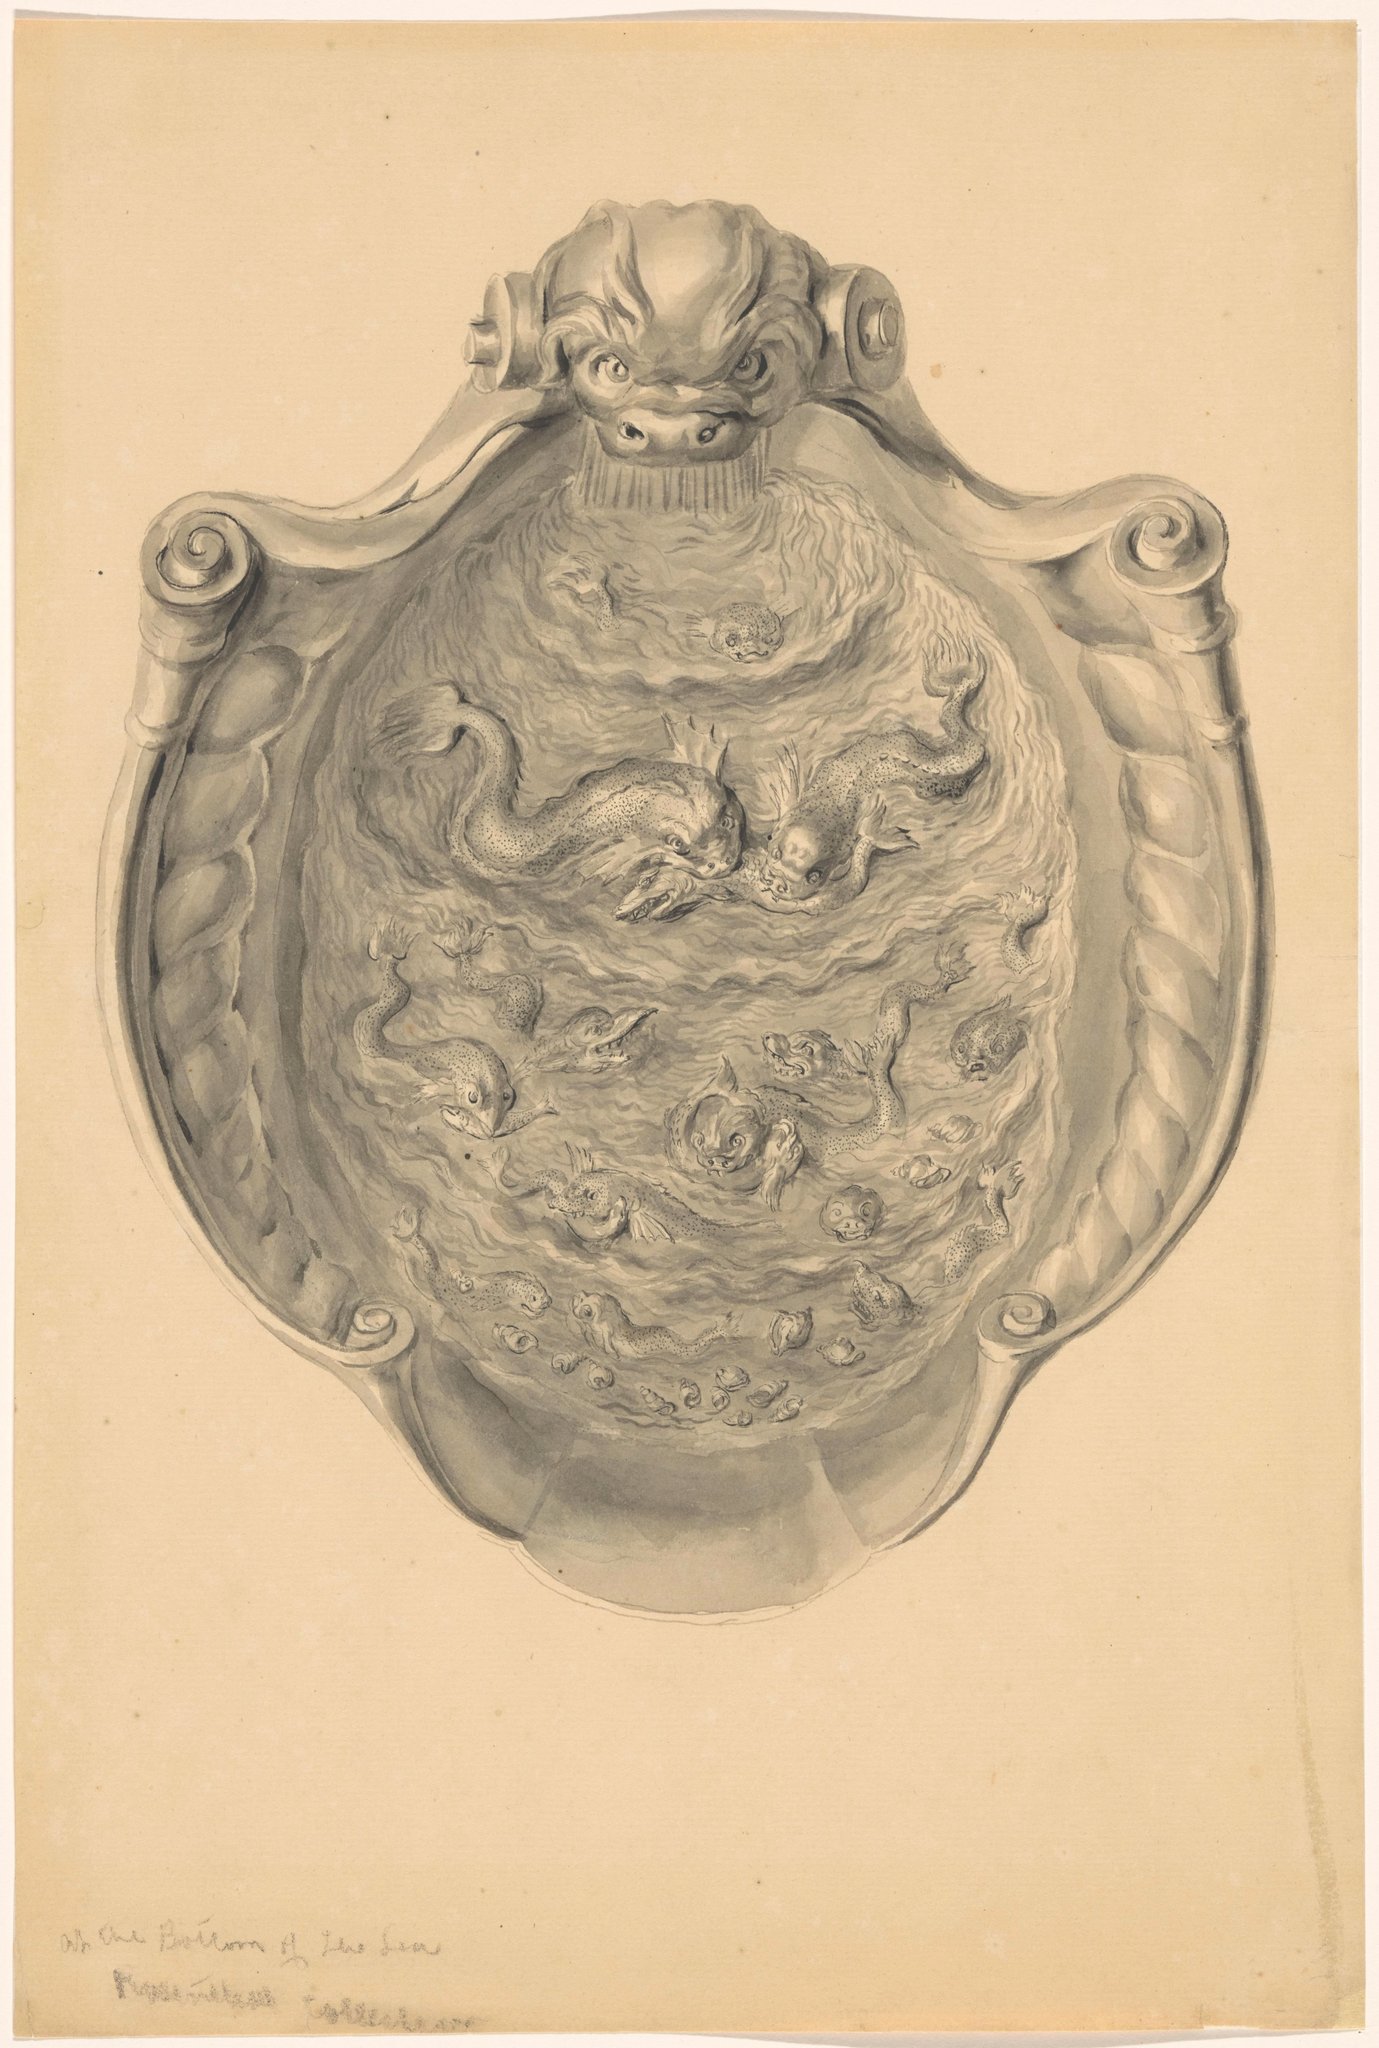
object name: album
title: Tekening van 17e eeuws zilver behorende bij een album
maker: Anonymous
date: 1725-1728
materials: paper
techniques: drawing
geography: amsterdam